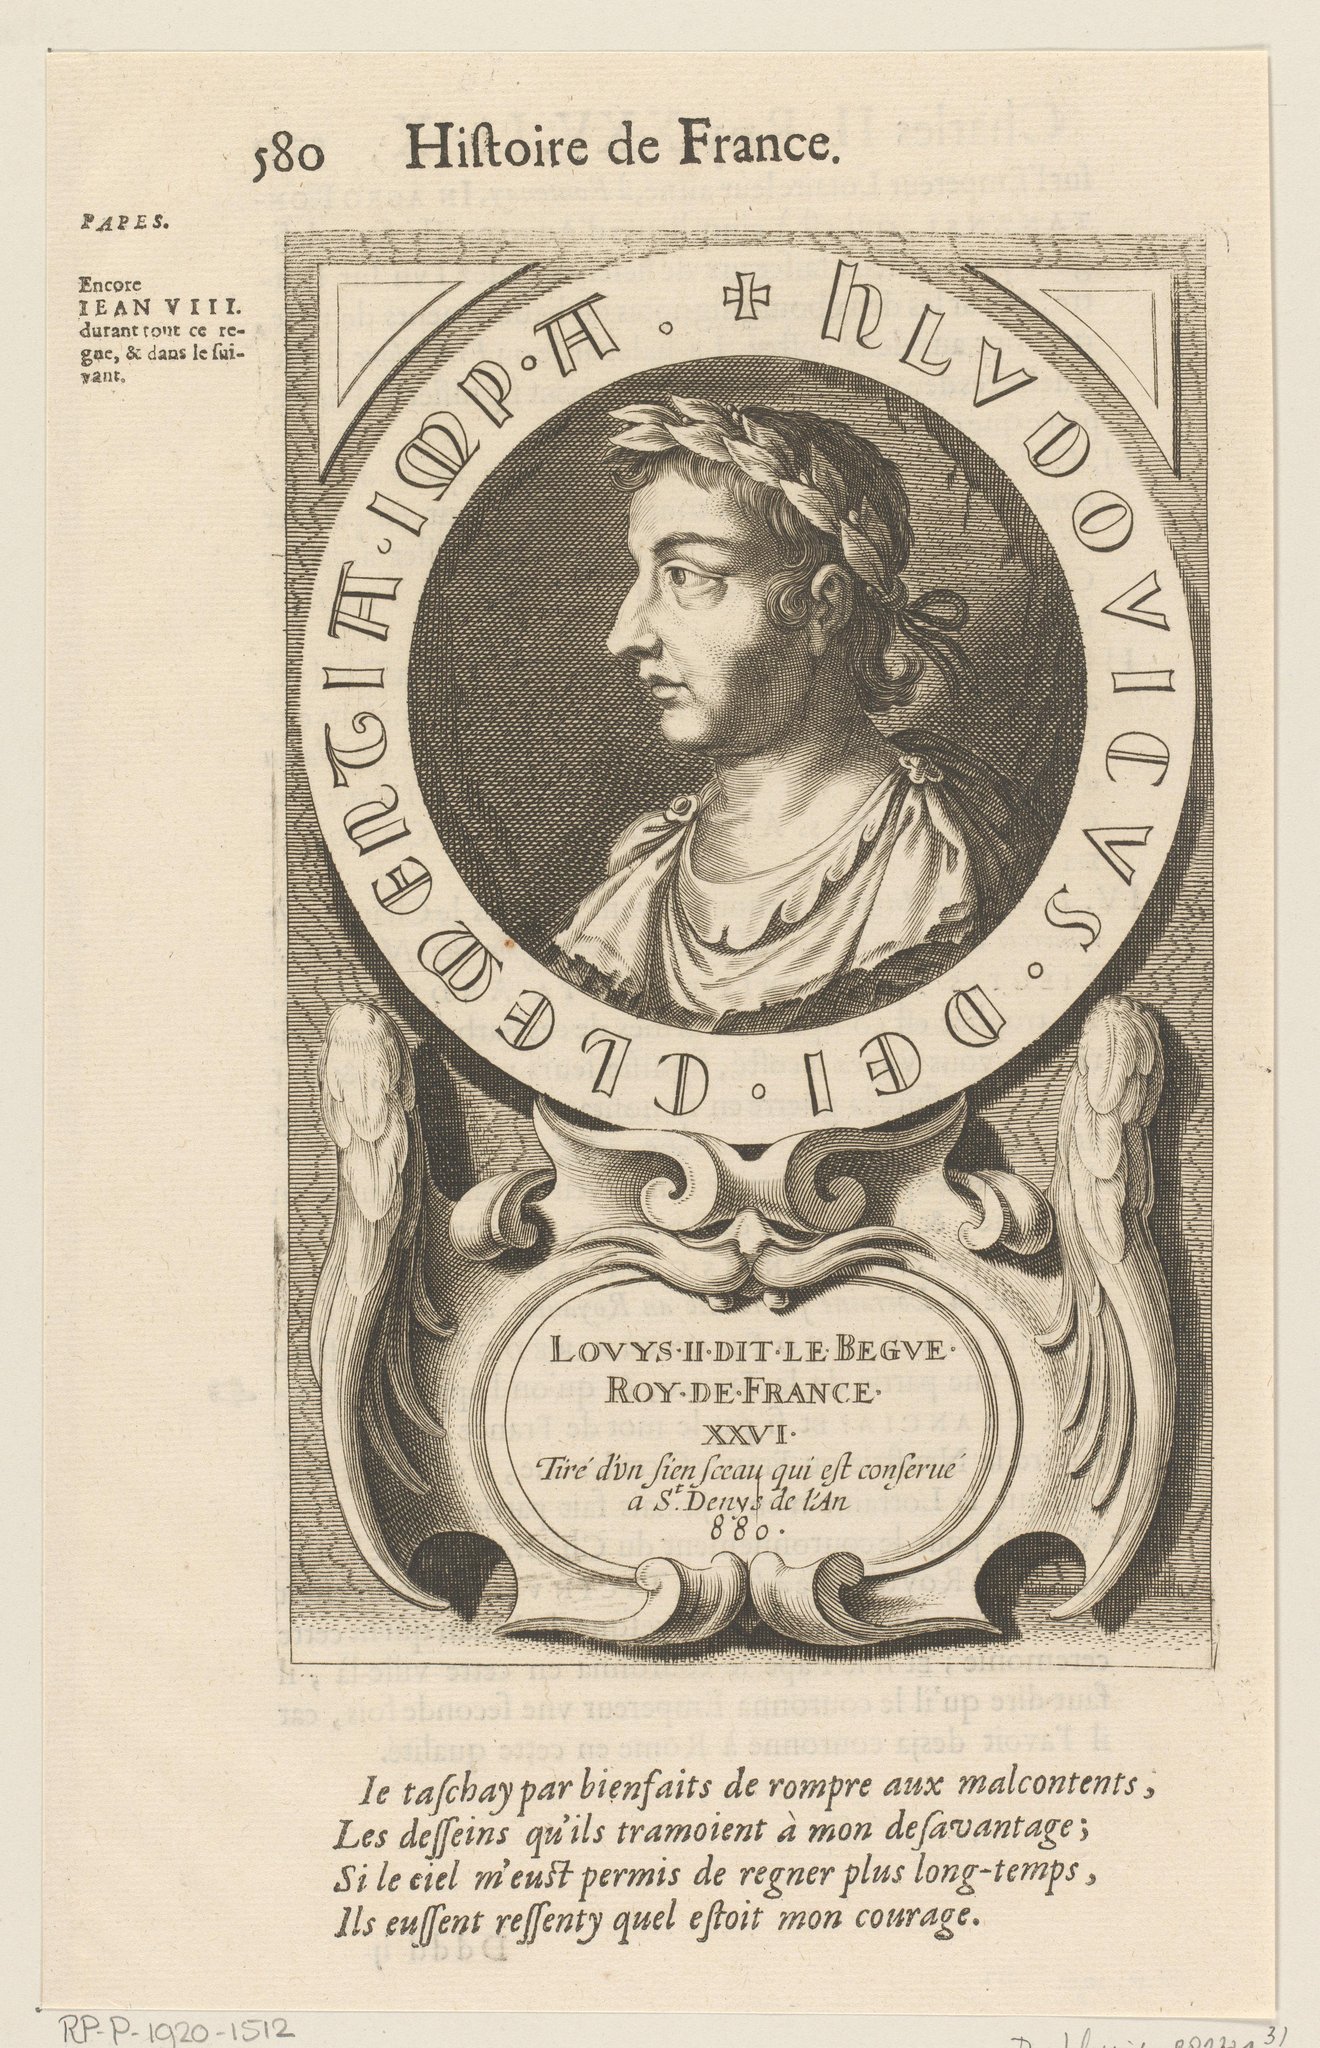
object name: book illustration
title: Portret van Lodewijk II, de Stamelaar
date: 1635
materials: paper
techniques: engraving, letterpress printing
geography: paris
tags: historical persons, ruler, sovereign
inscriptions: collector's mark: Lugt 2228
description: Prent uit: Eudes de Mézeray, François. Histoire de France, depuis Faramond jusqu’au regne de Louis le Juste (...). 3 dln. Parijs: Denis Thierry, Jean Guignard en Claude Barbin, 1635, dl. 1. Prent waarschijnlijk voor het eerst verschenen in: Bie, Jacques de. Les vrais portraits des rois de France (...). Parijs: Jacques de Bie en Pierre Rocolet, 1634. Prent ook gebruikt in latere publicaties.